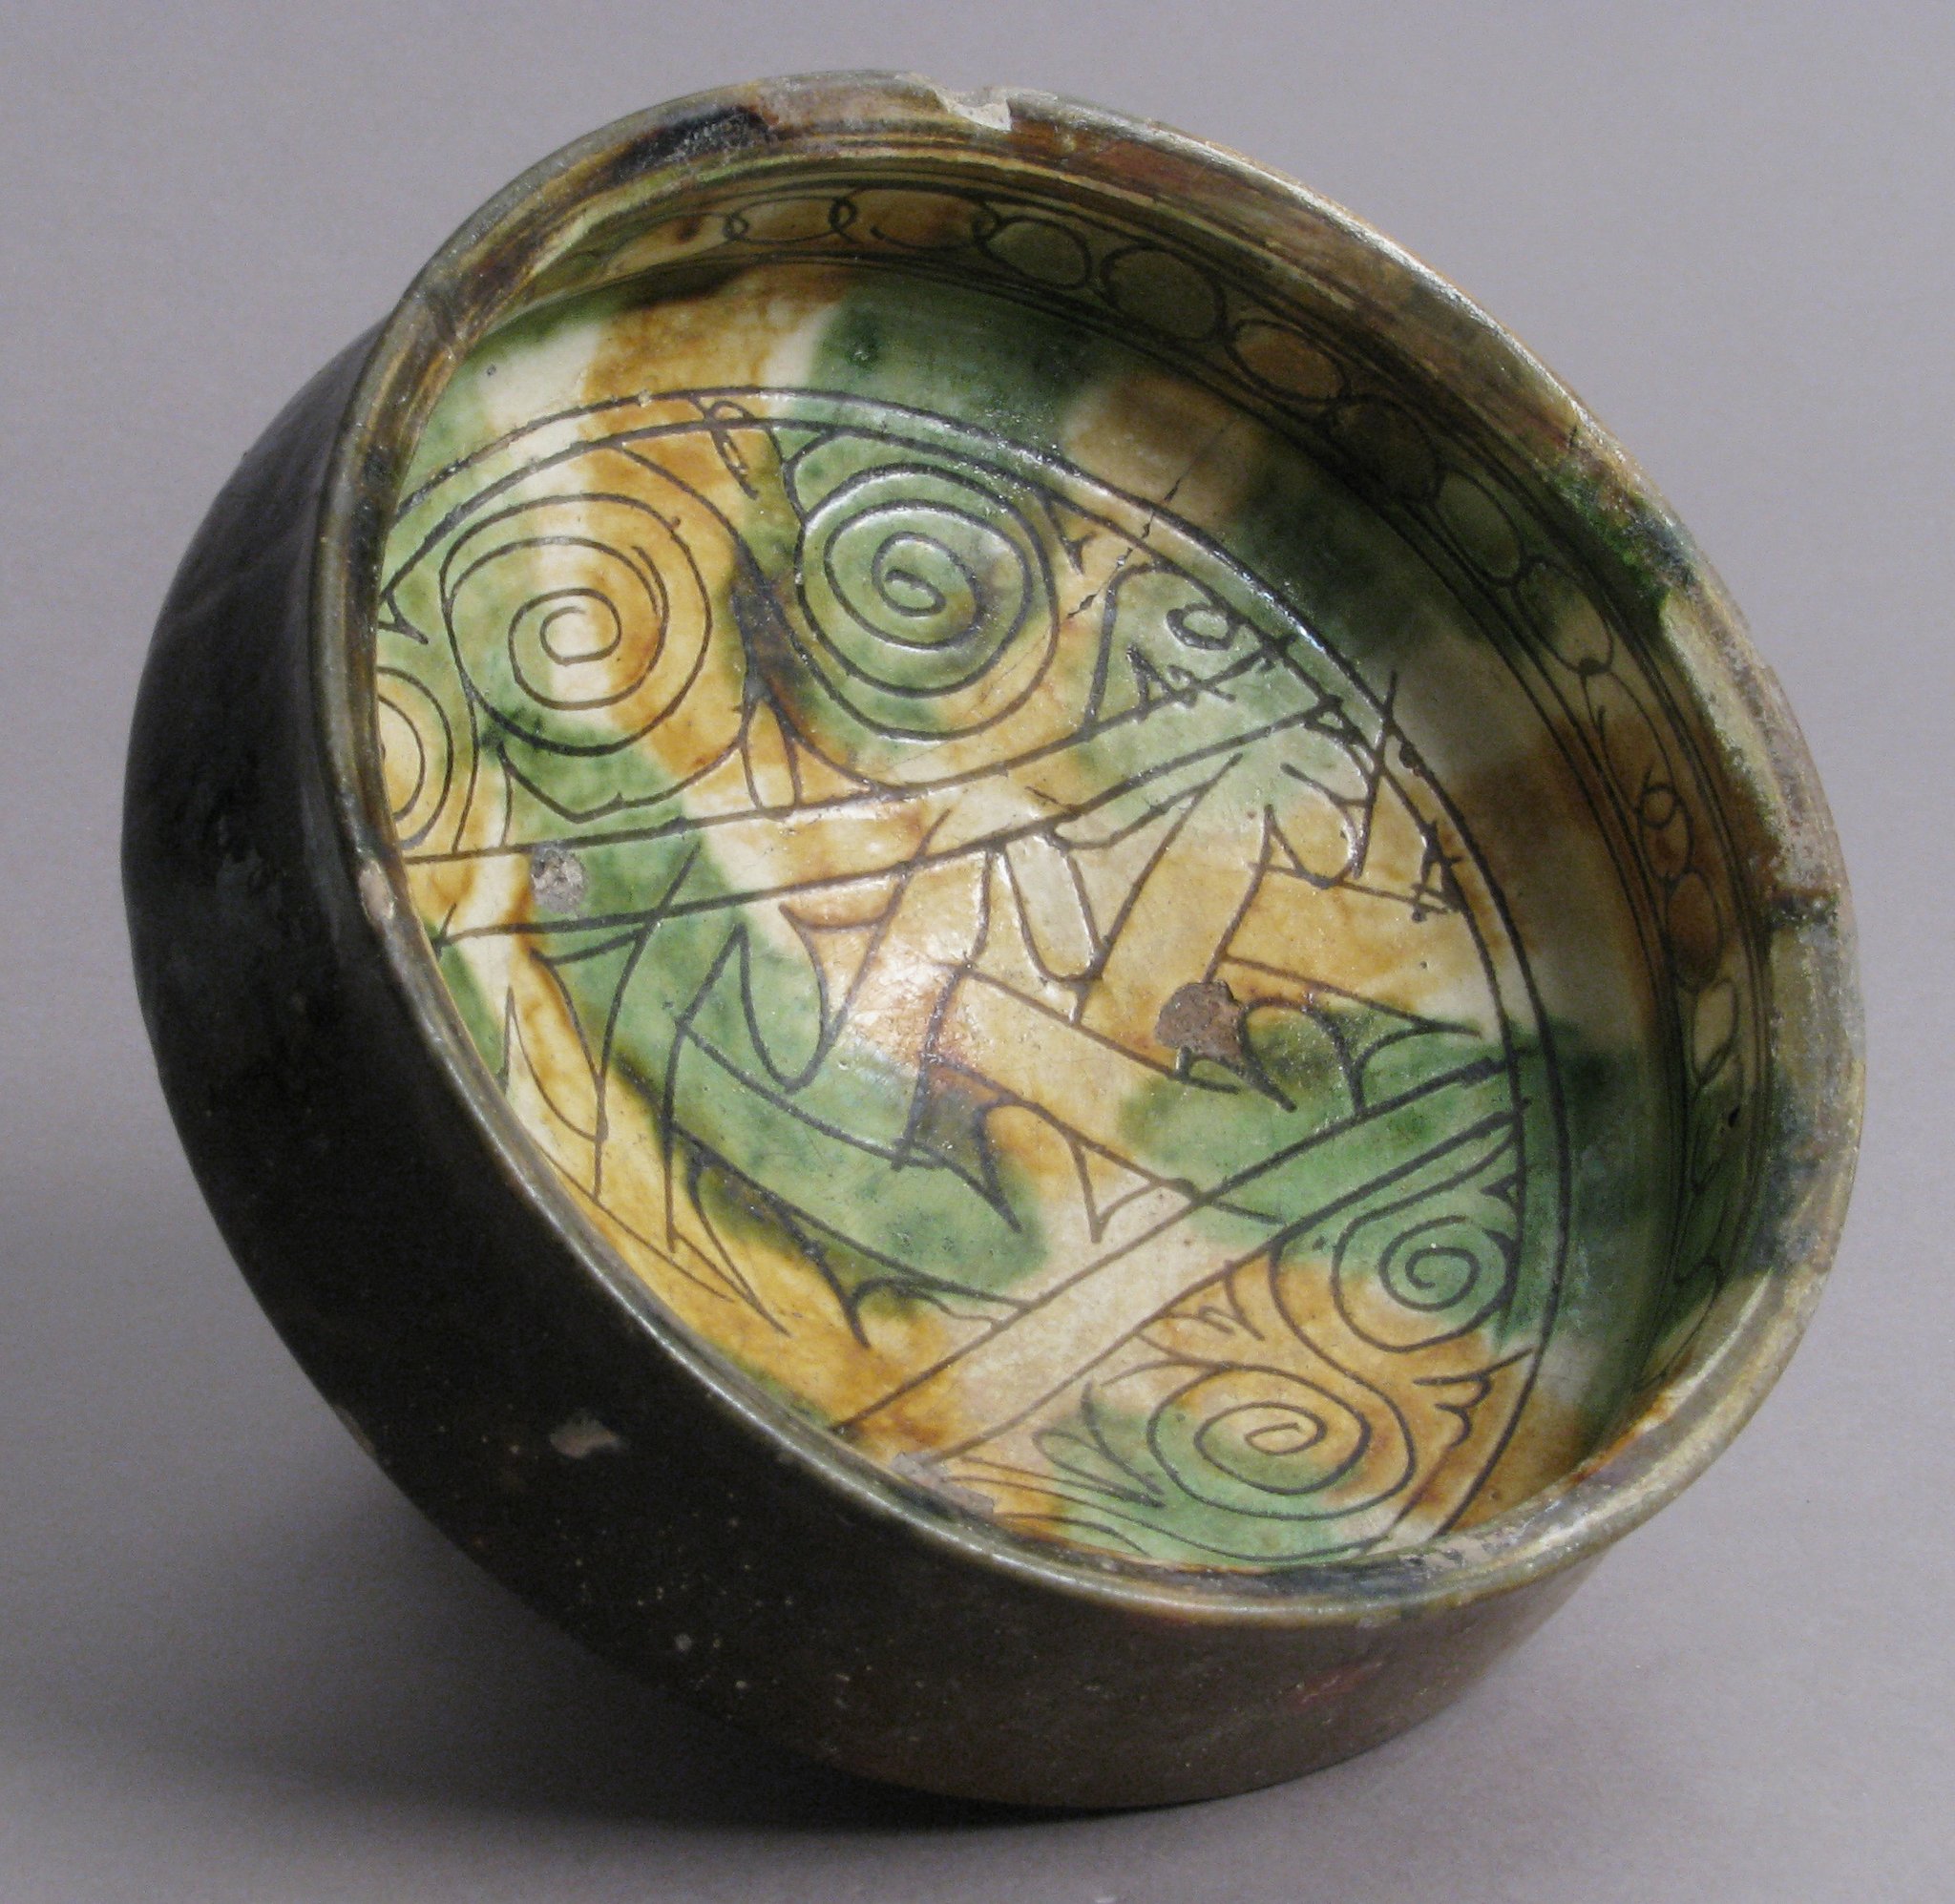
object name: bowl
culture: byzantine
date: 1101-1300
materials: earthenware, glaze